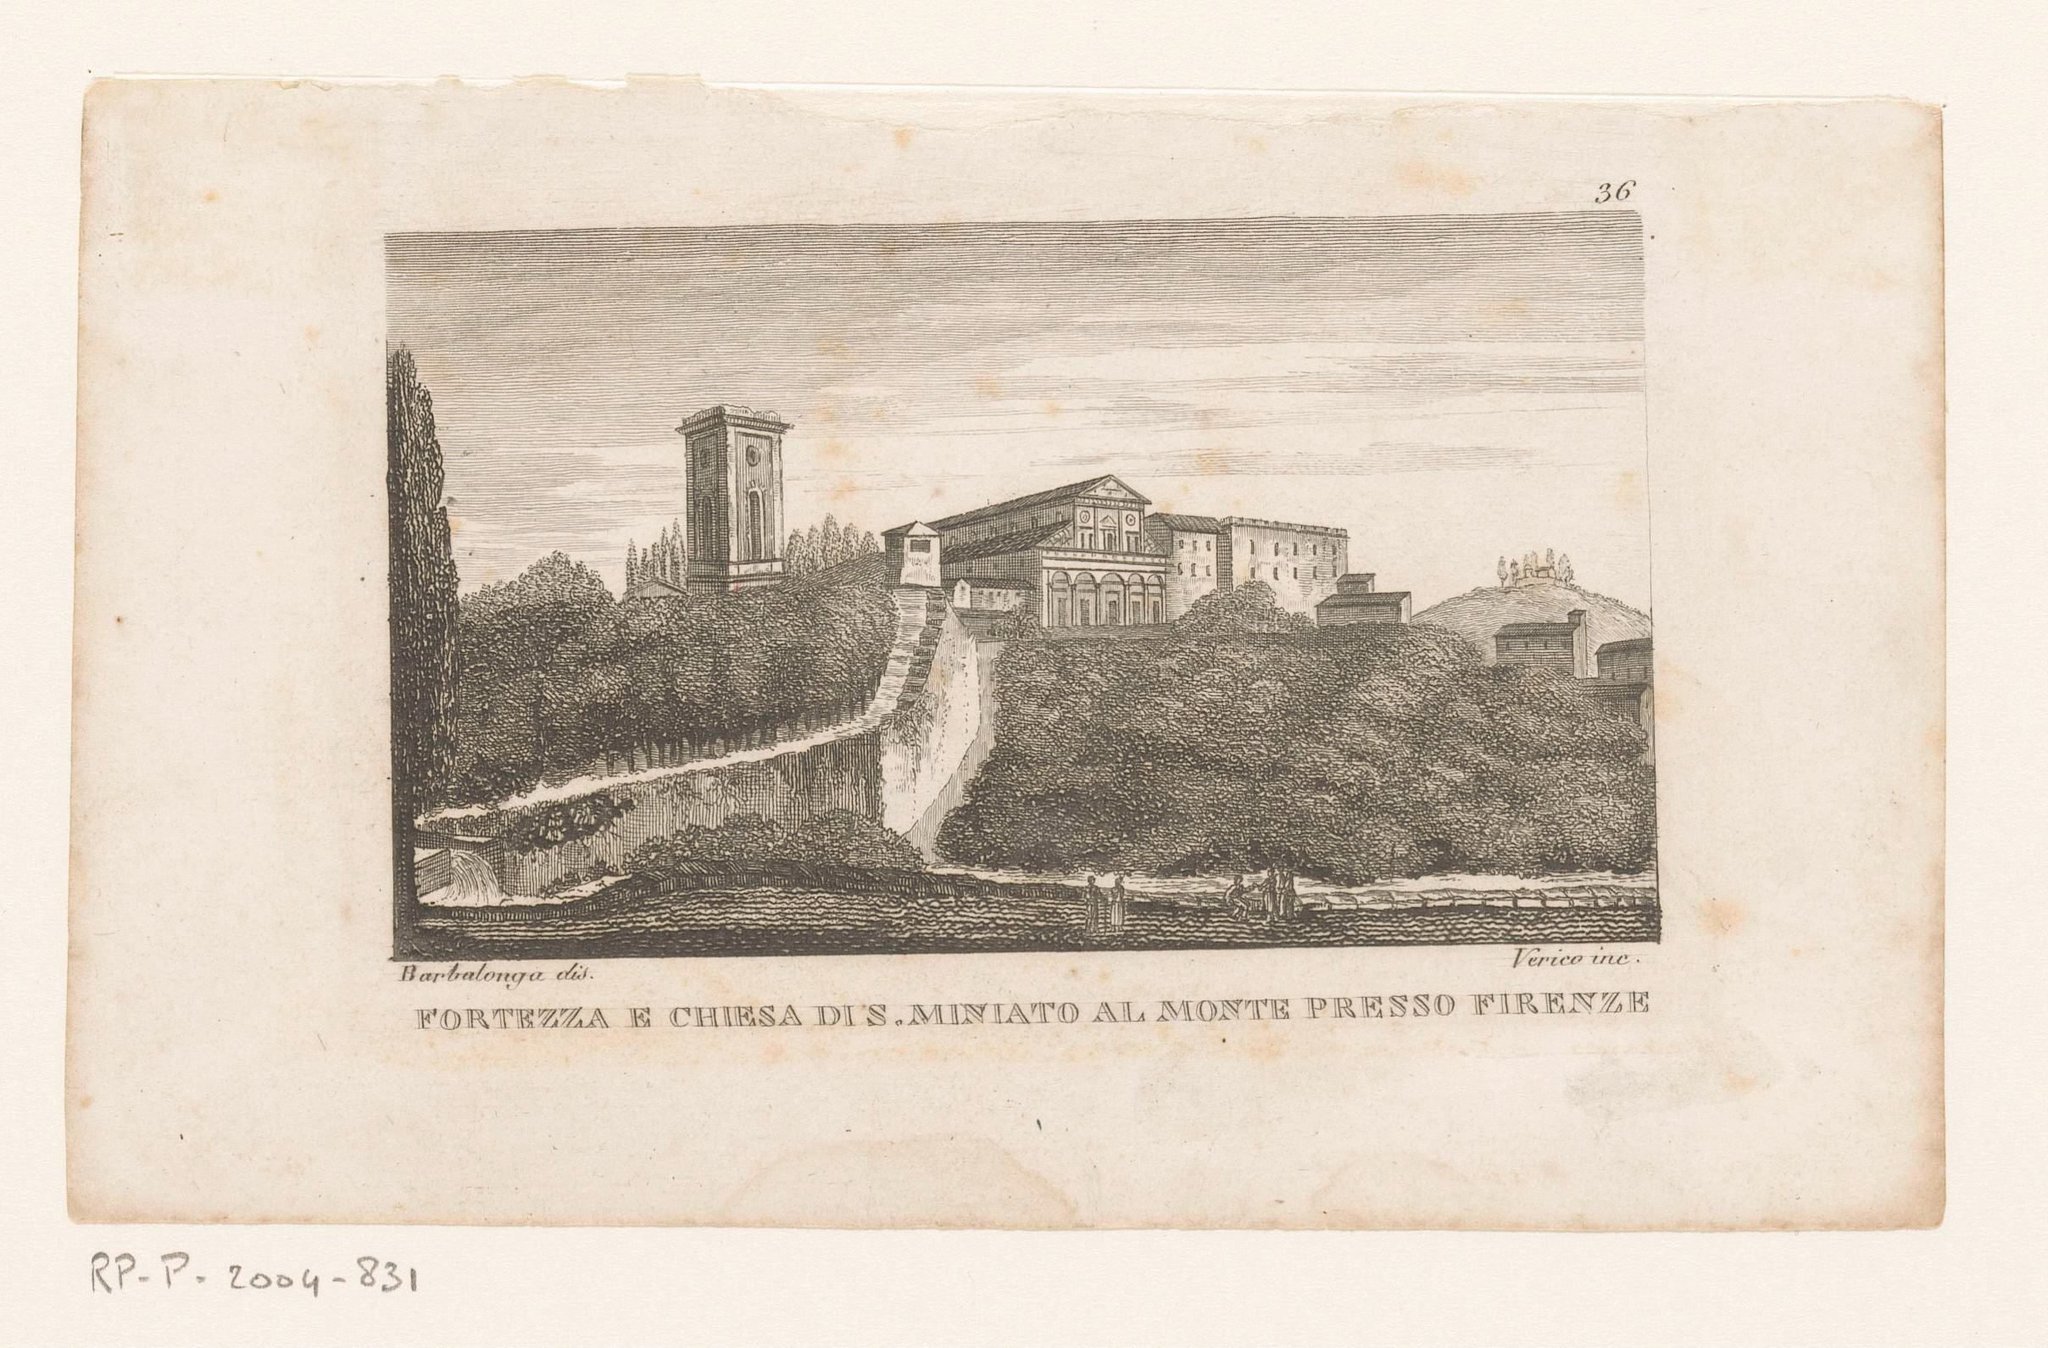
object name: print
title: Fortezza e chiesa di S. Miniato al monte presso Firenze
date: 1785-1875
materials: paper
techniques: etching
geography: italy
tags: city-view in general; 'veduta', building of church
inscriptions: collector's mark: Lugt 2228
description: Gezicht op de San Miniato al Monte, gelegen bovenop een heuvel te Florence. Links de onafgewerkte klokkentoren. Genummerd rechtsboven: 36.